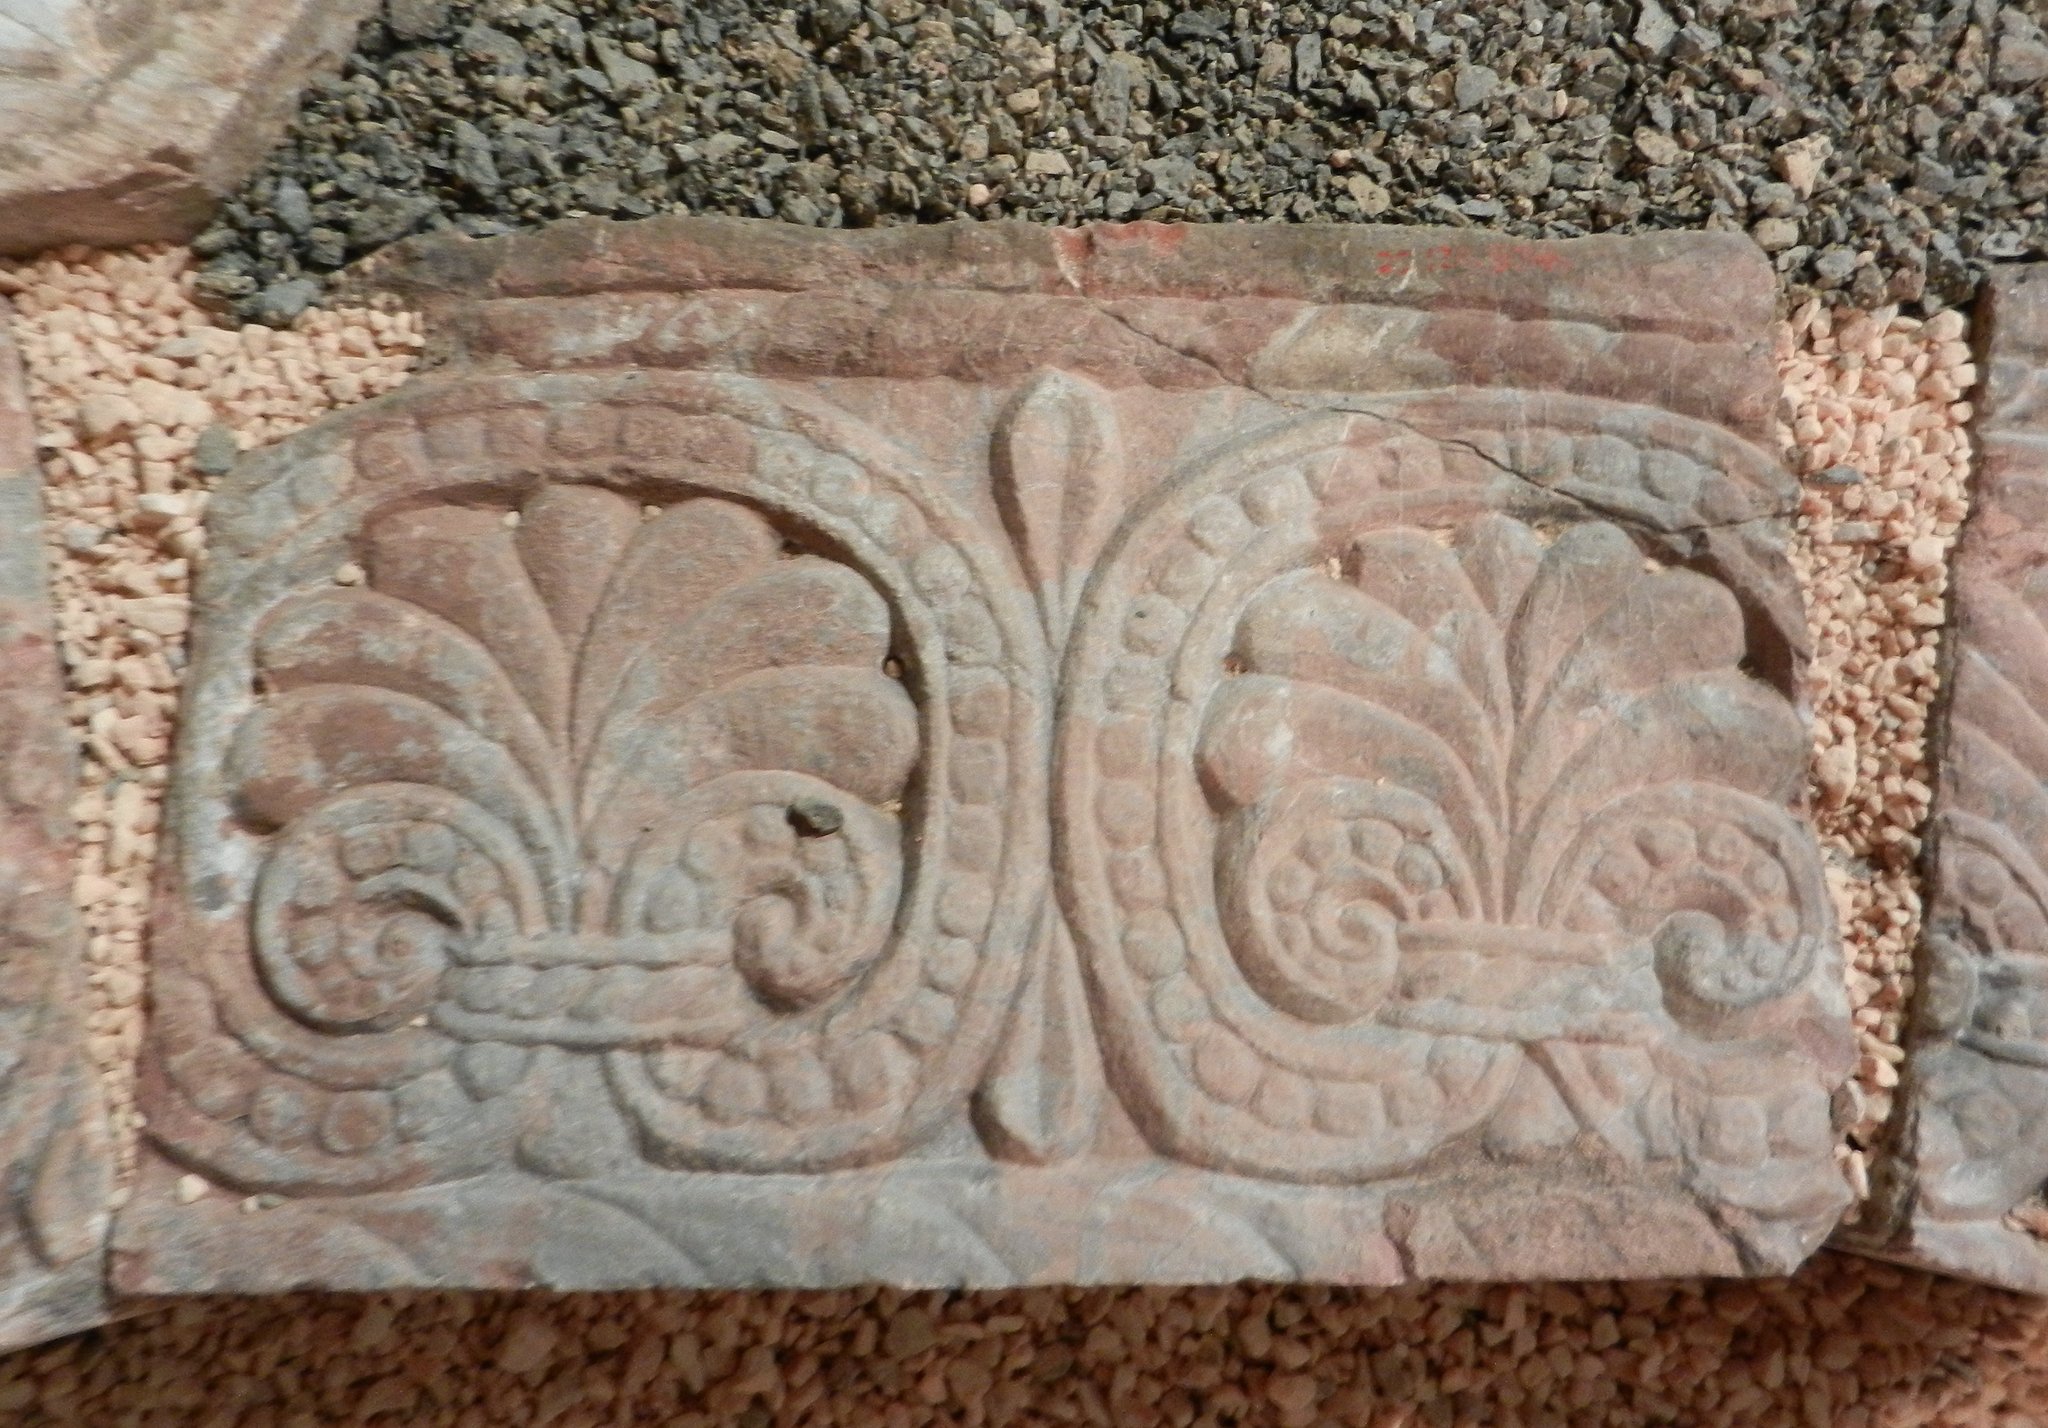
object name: fragment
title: Lintel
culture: catalan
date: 1130-1140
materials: marble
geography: france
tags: palmettes